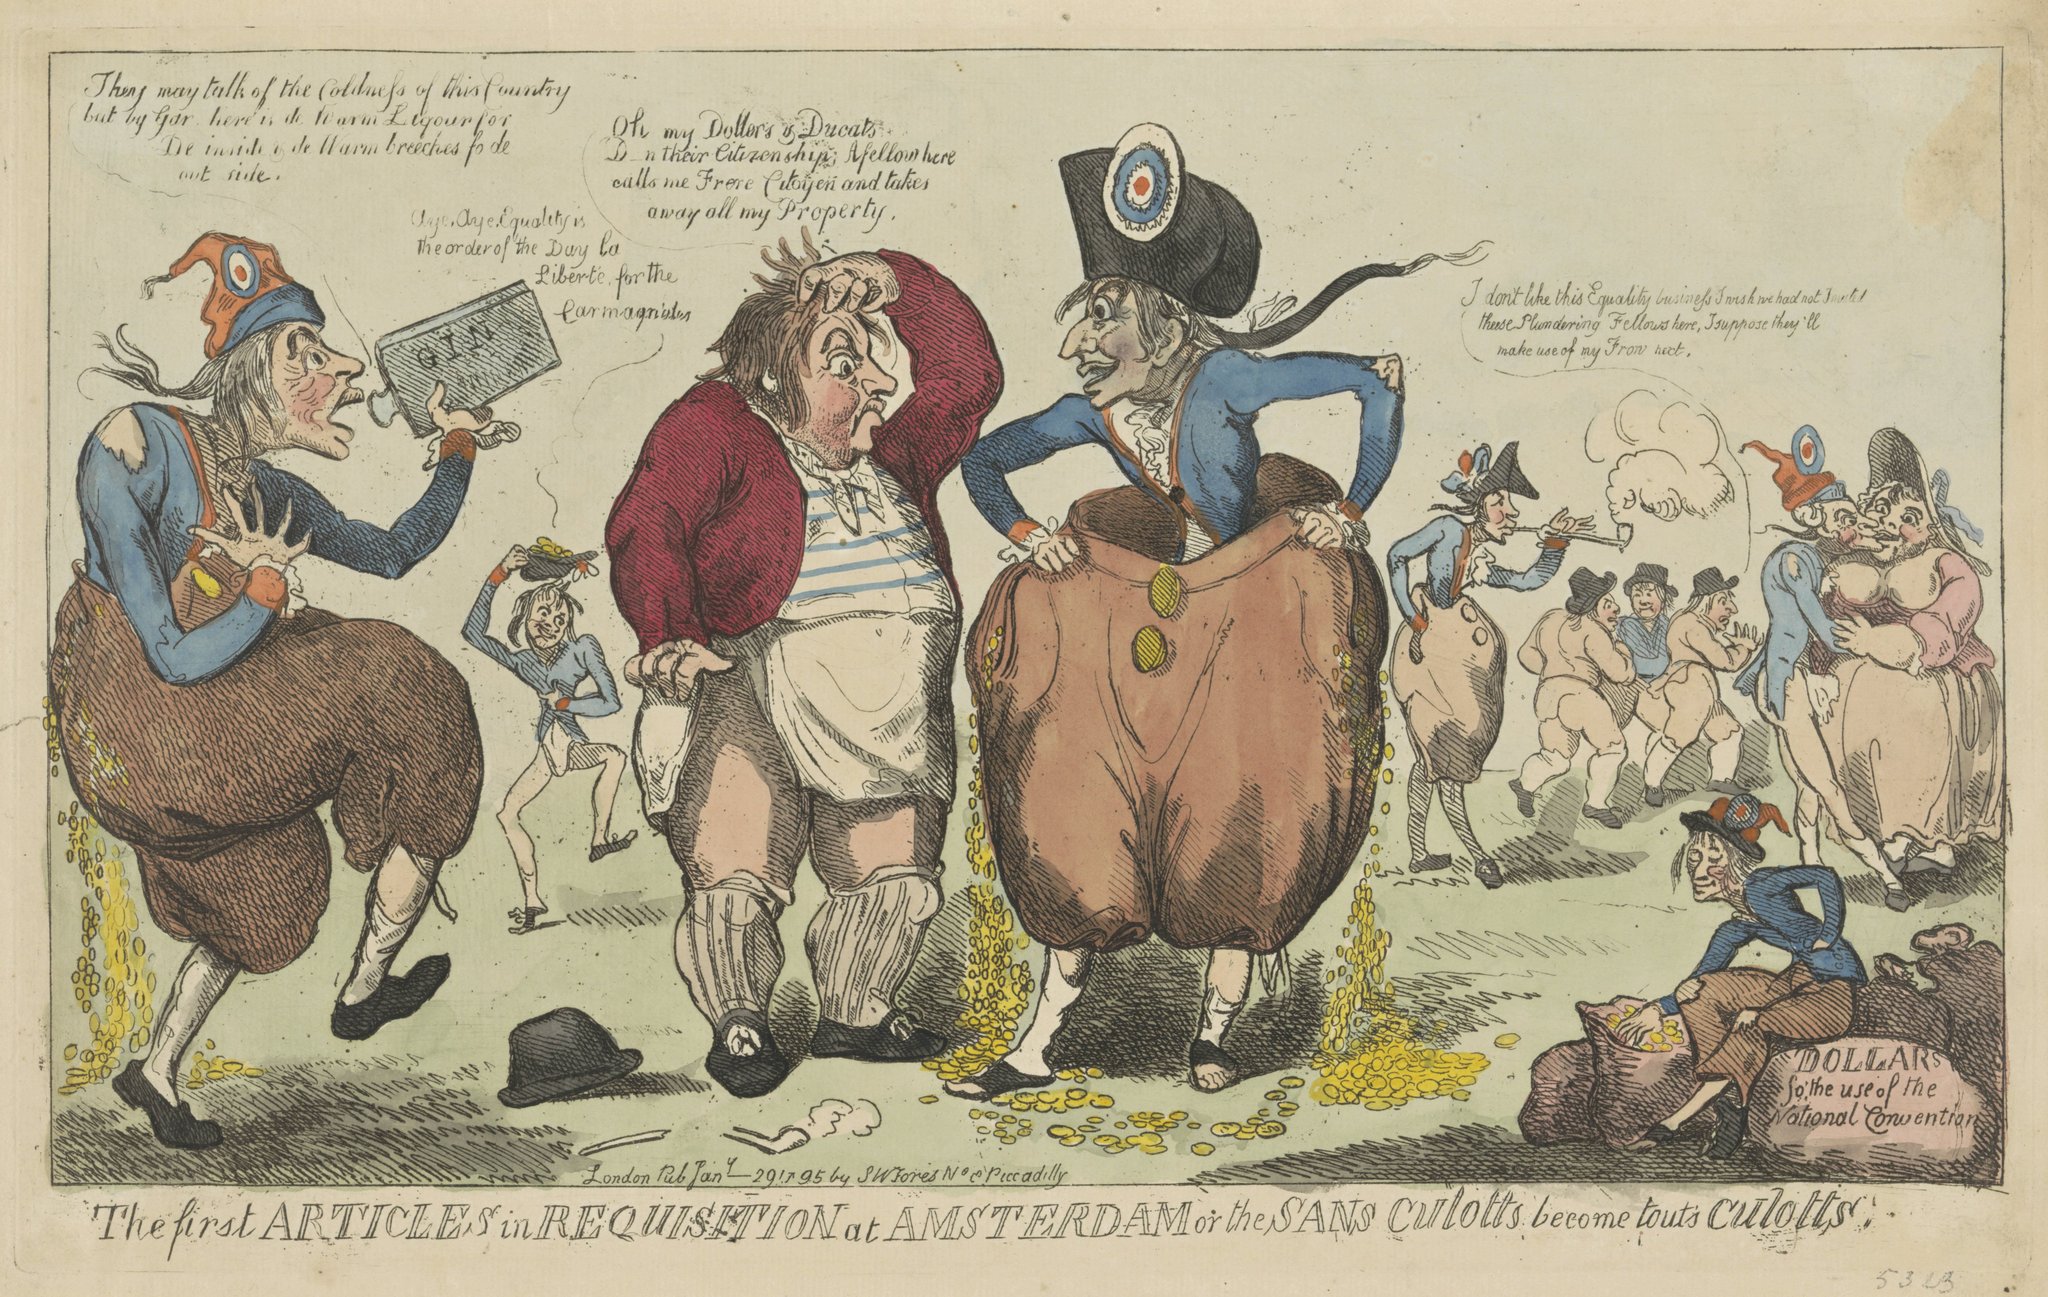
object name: cartoon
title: The first Articles in Requisition at Amsterdam or the Sans Culotts become touts Culotts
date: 1795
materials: paper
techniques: etching, hand coloring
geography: london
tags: trousers, breeches, etc. (trousers) (+ men's clothes), political caricatures and satires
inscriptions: collector's mark: Lugt 2228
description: Engelse spotprent op de Franse rekwisitie in januari 1795. Een Franse sansculotte heeft een wijde broek van een Hollander aangetrokken, waaruit het Hollandse goud valt. Naast hem de beteuterd kijkende Hollander in onderbroek. Links drinkt een andere sansculotte, eveneens met een Hollandse met goud gevulde broek, uit een fles jenever. Rechts vermaakt een Fransman zich met een rondborstige Nederlandse vrouw. Spotprent op de vergoedingen die de Bataafse Republiek aan Frankrijk moest betalen.